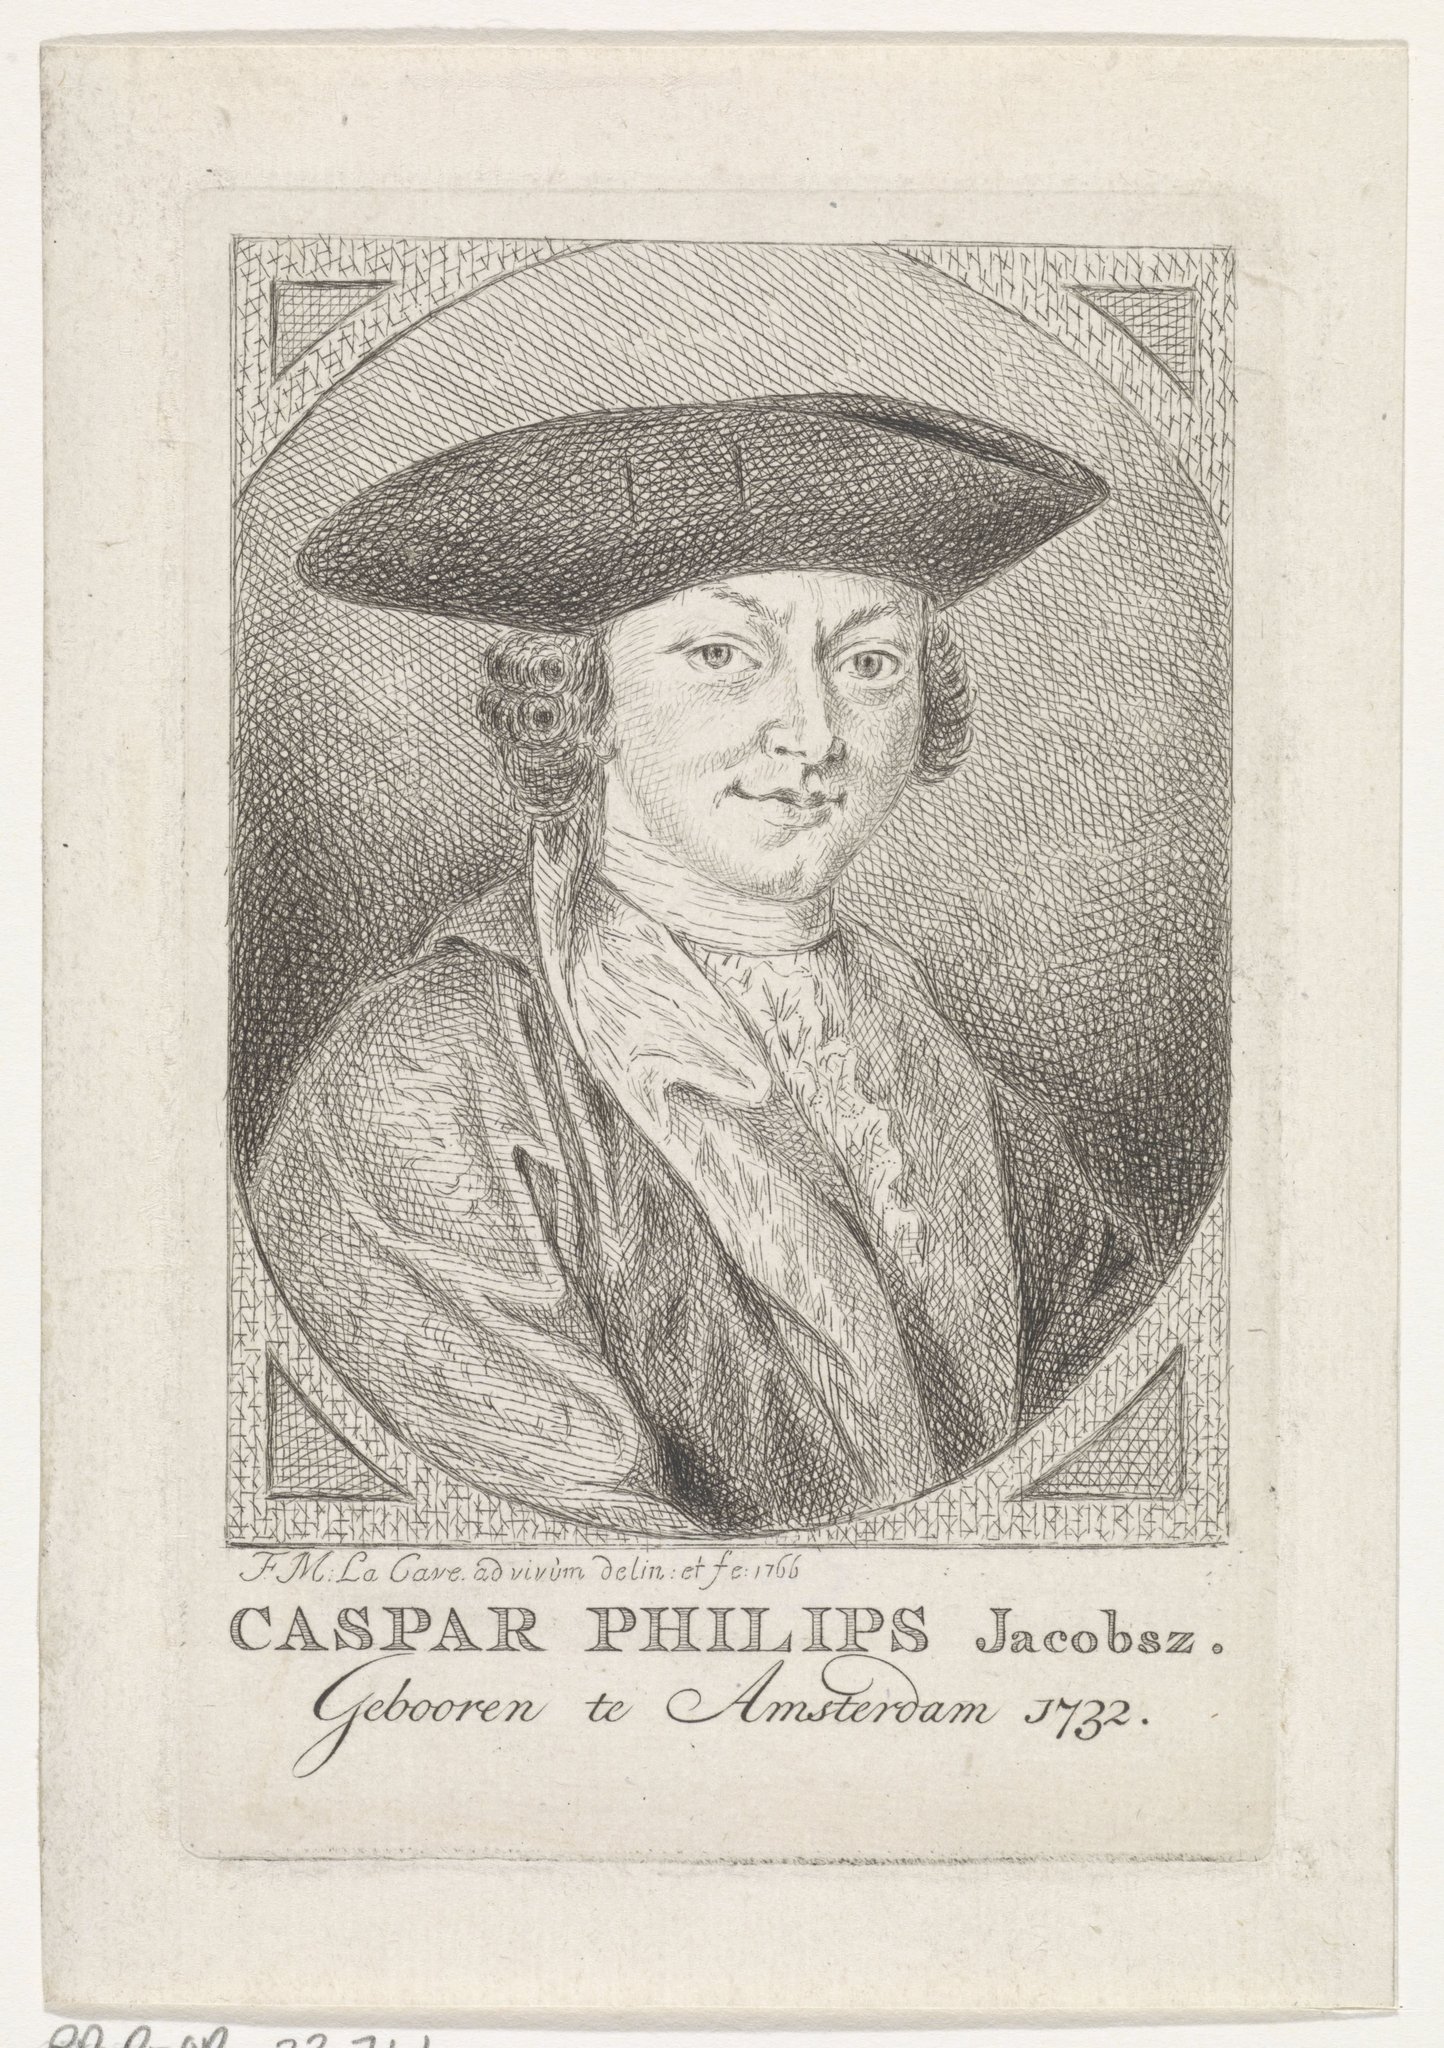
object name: print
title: Portret van Caspar Jacobsz. Philips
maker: françois morellon la cave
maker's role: draughtsman, print maker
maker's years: 1696-1768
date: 1766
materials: paper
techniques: etching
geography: amsterdam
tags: amsterdam, print maker, draughtsman, caspar jacobsz. philips, portrait, self-portrait of graphic artist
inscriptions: collector's mark: Lugt 2228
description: Portret van tekenaar en graveur Caspar Jacobsz. Philips met een steekhoed op zijn hoofd.